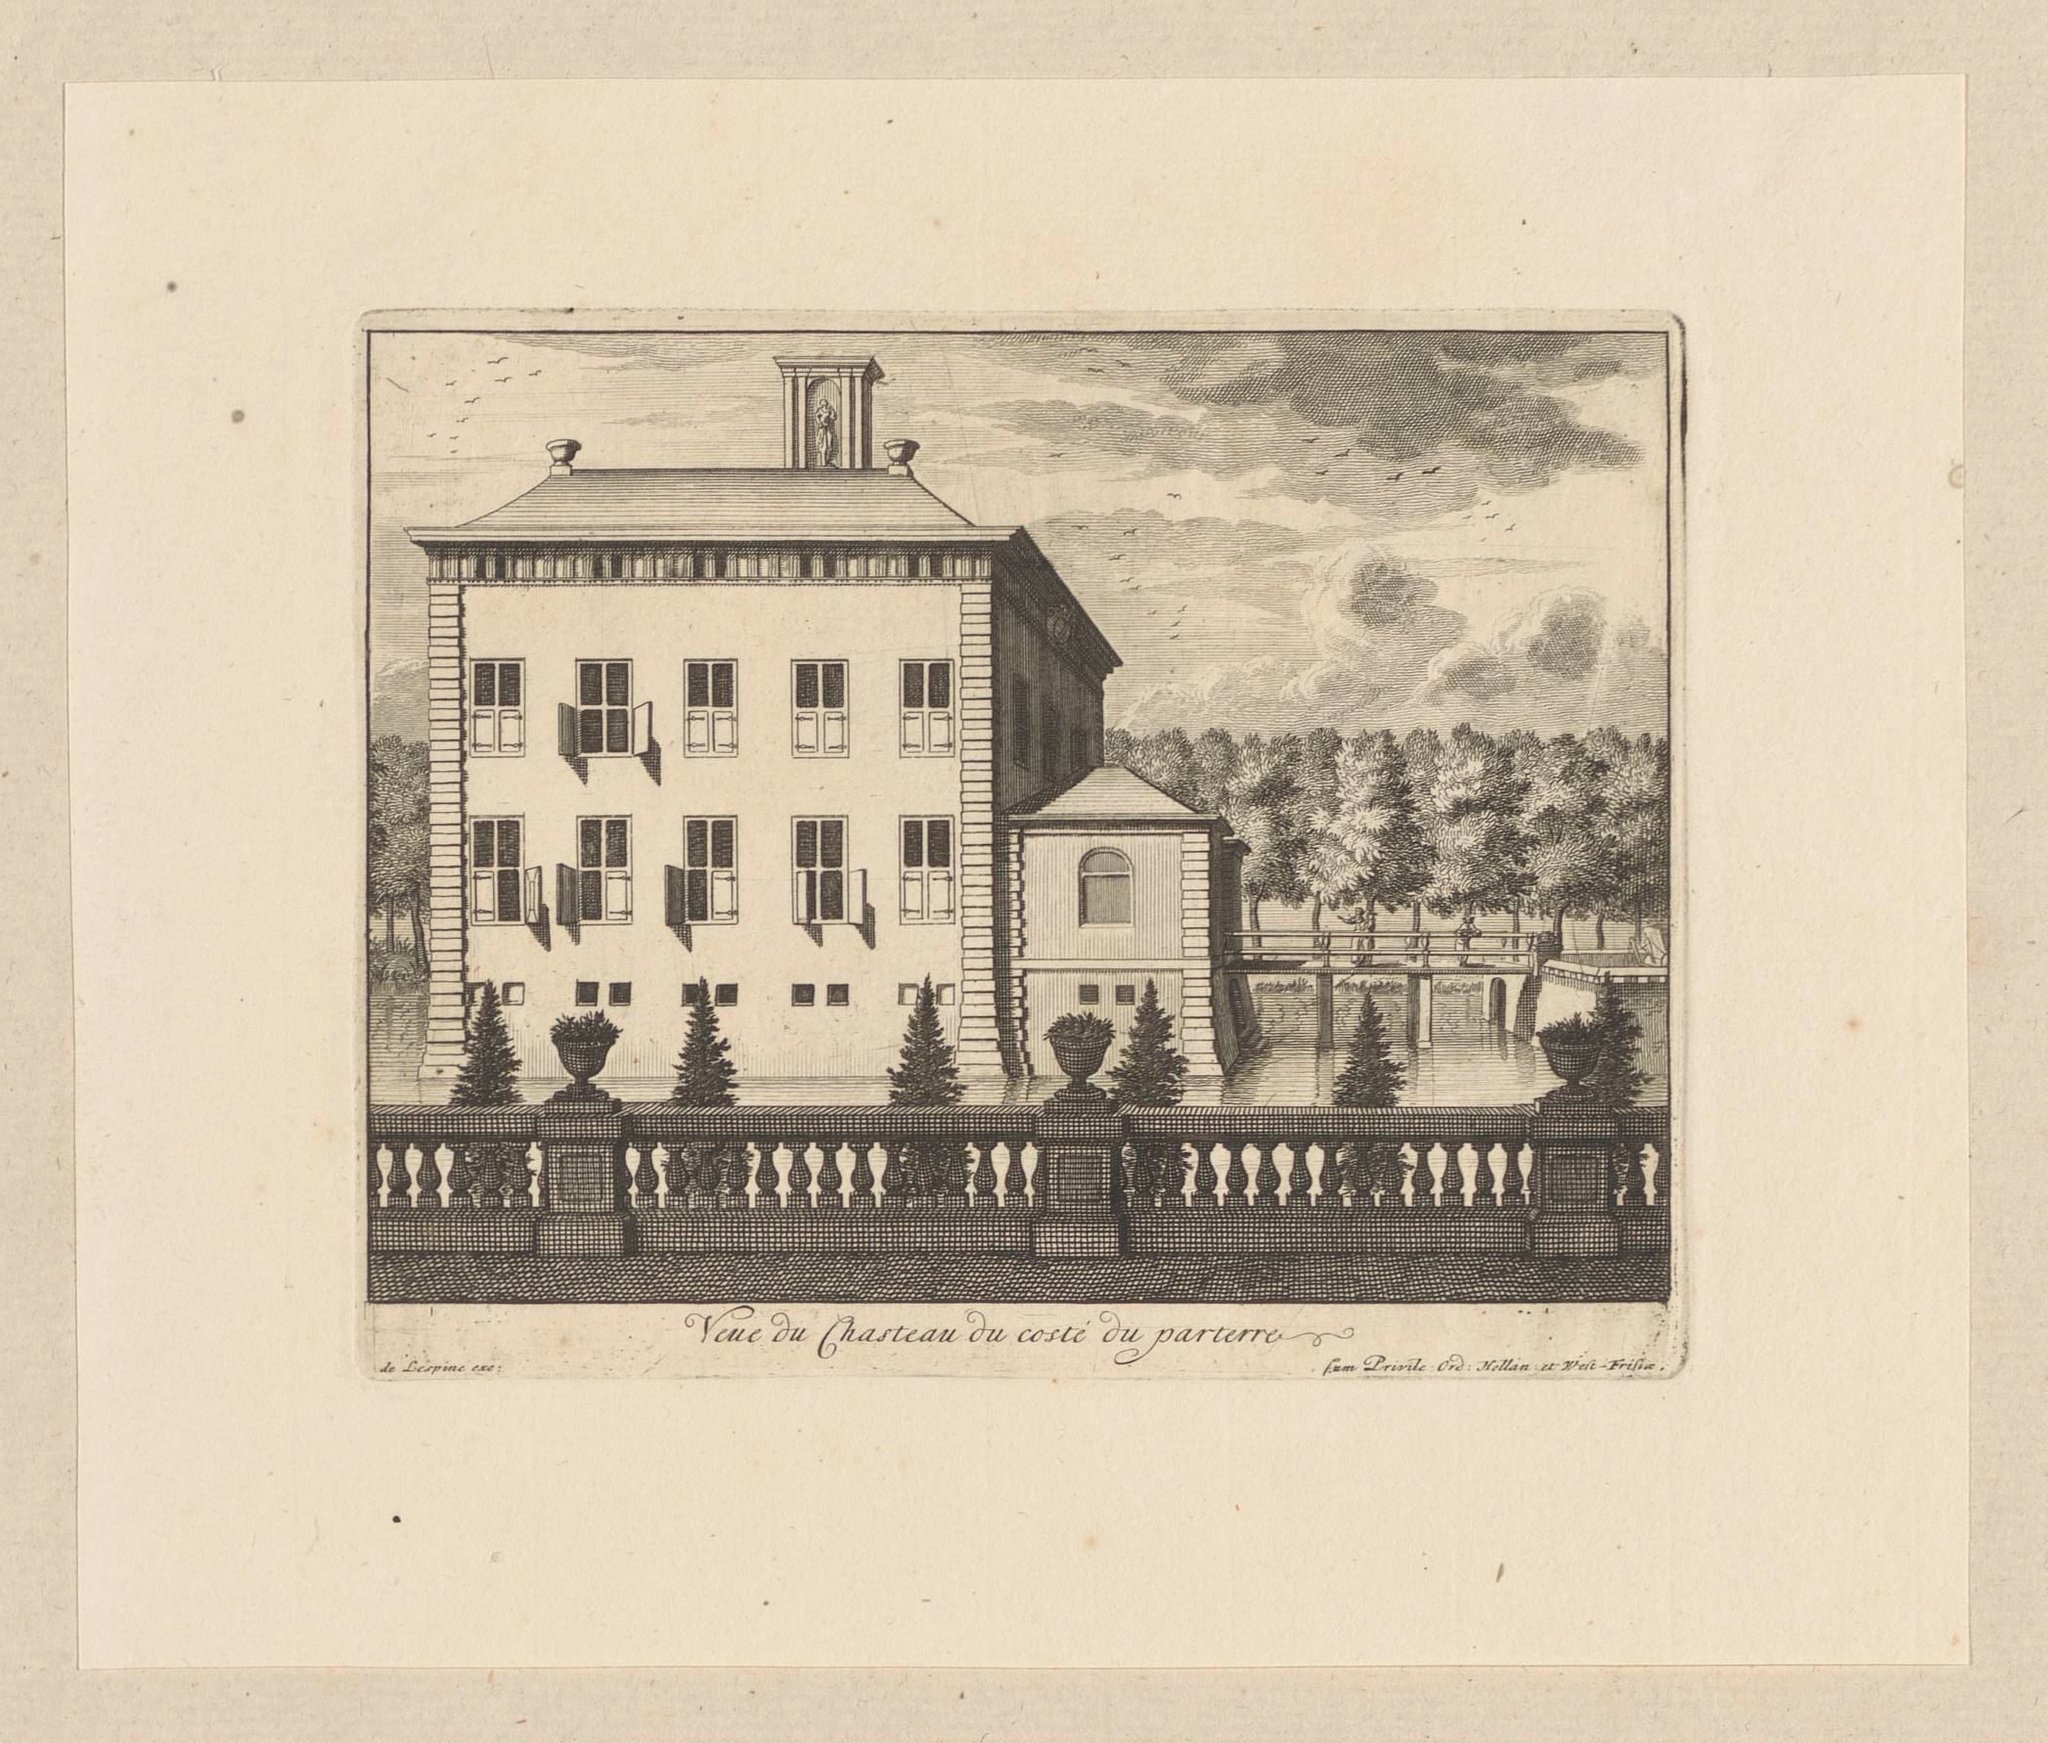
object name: print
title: Veue du chasteau du costé du parterre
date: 1680-1696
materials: paper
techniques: engraving, etching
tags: magdalena poulle, castle, exterior ~ architectural design or model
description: Zijaanzicht van Kasteel Gunterstein te Breukelen met de toegangsbrug rechts.